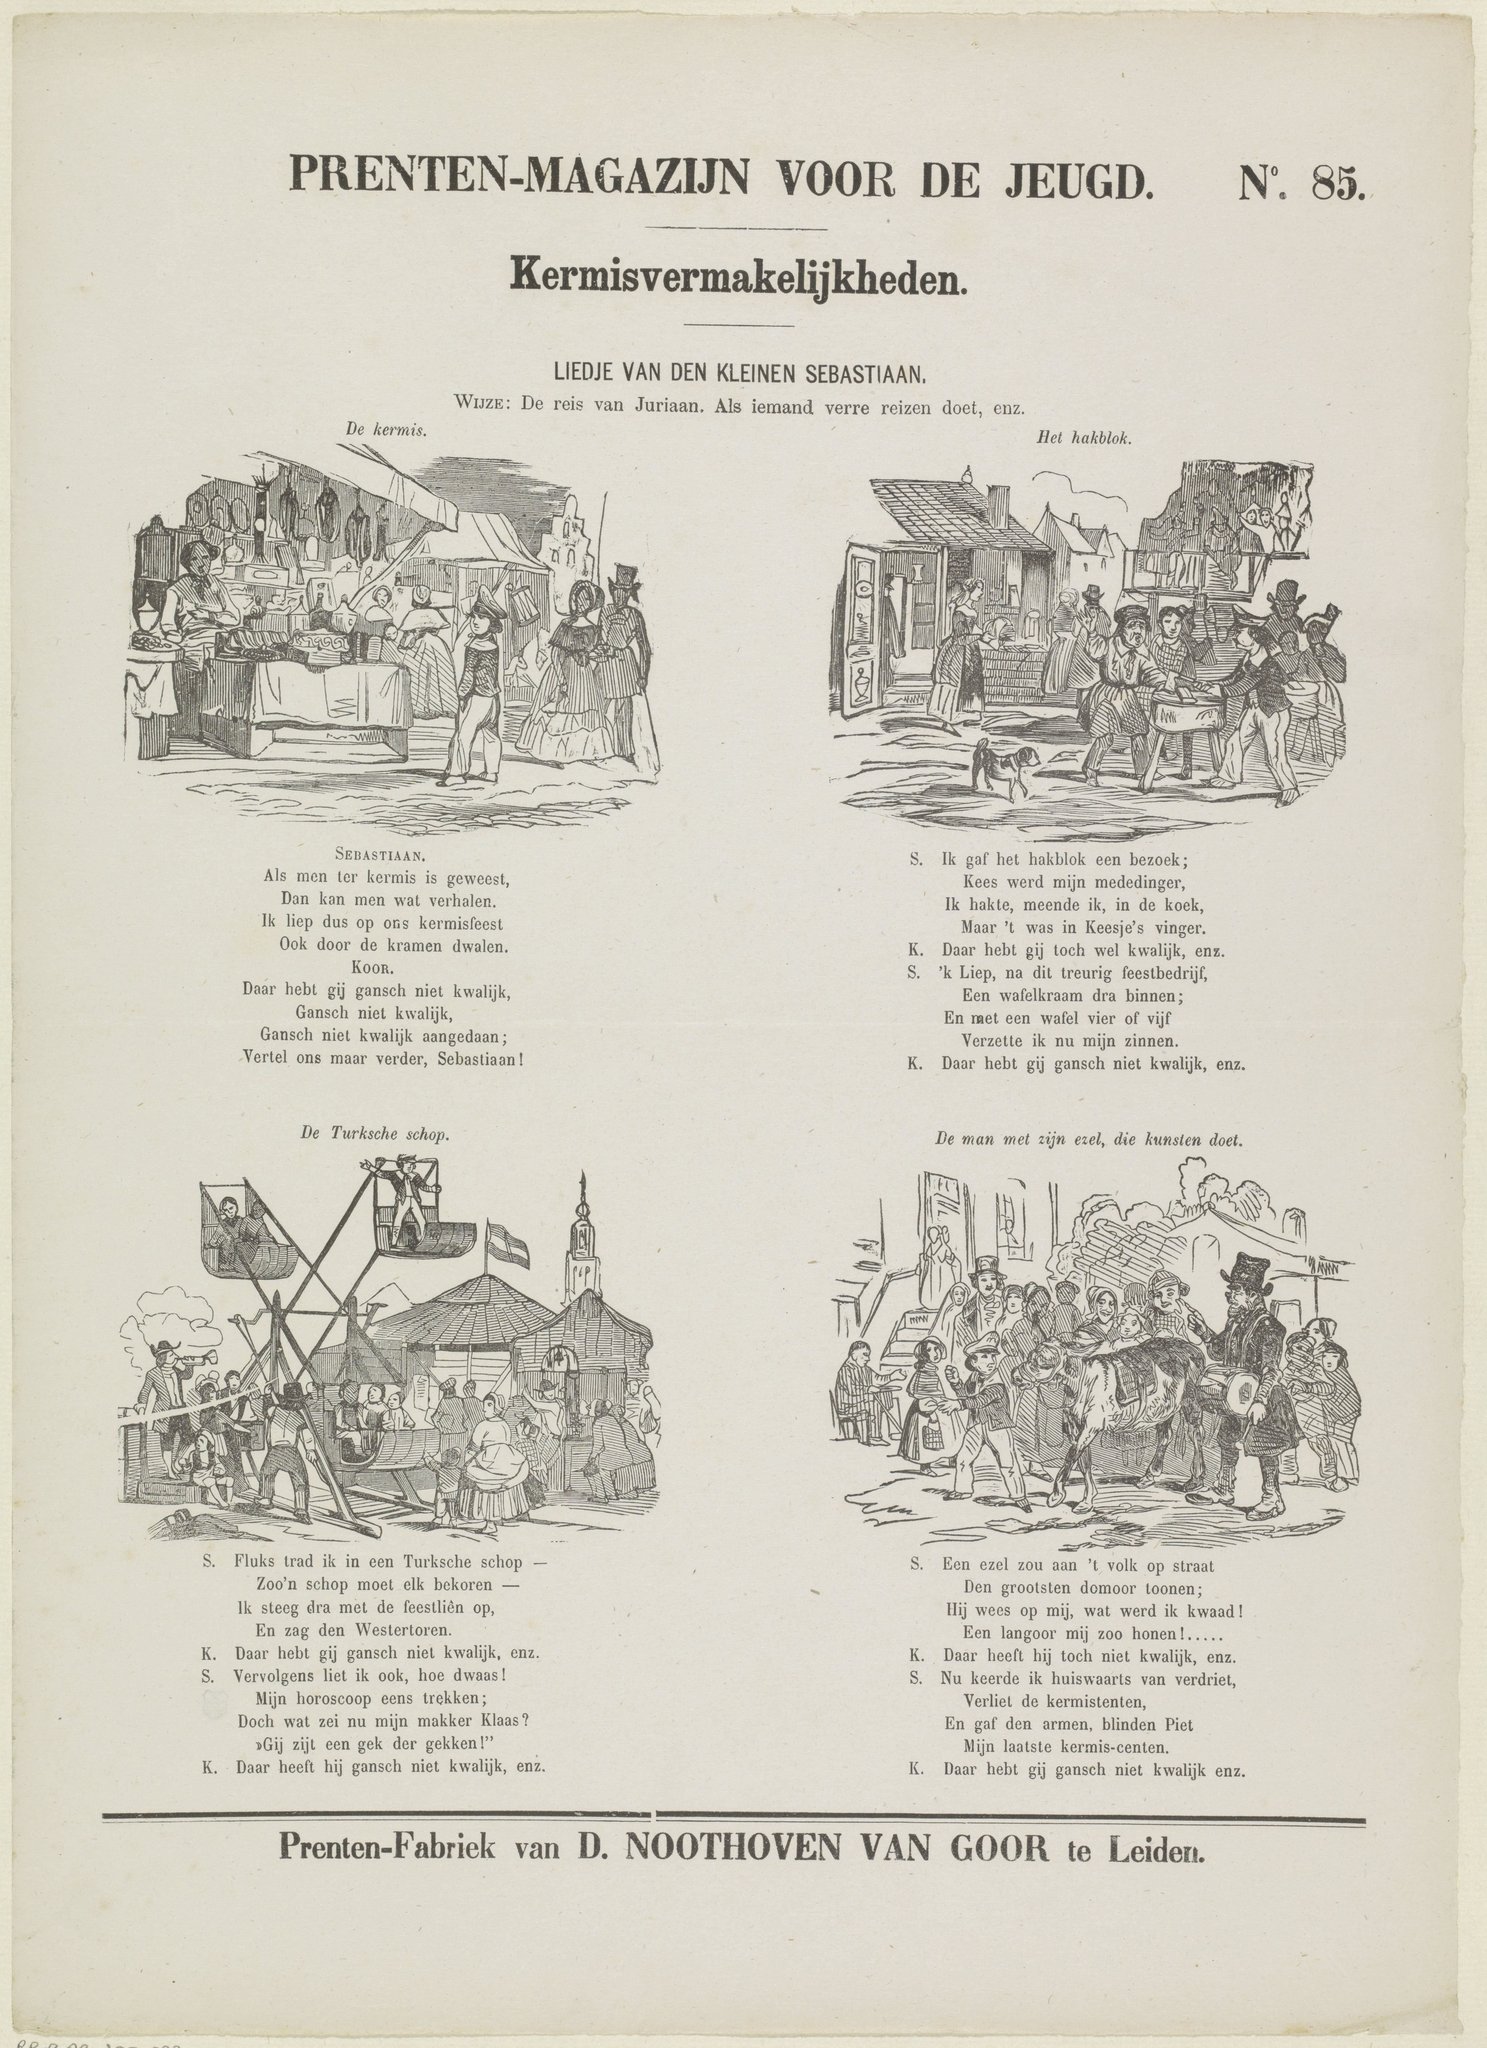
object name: print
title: Liedje van den kleinen Sebastiaan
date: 1850-1881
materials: paper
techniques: letterpress printing, engraving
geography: netherlands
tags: fancy fair, performance in the open air (pleasure fair), pleasure fair and circus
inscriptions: collector's mark: Lugt 2760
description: Blad met 4 kermistaferelen. Boven elke voorstelling een titel en onder elke voorstelling verzen uit het liedje van de kleine Sebastiaan. Genummerd rechtsboven: No. 85.